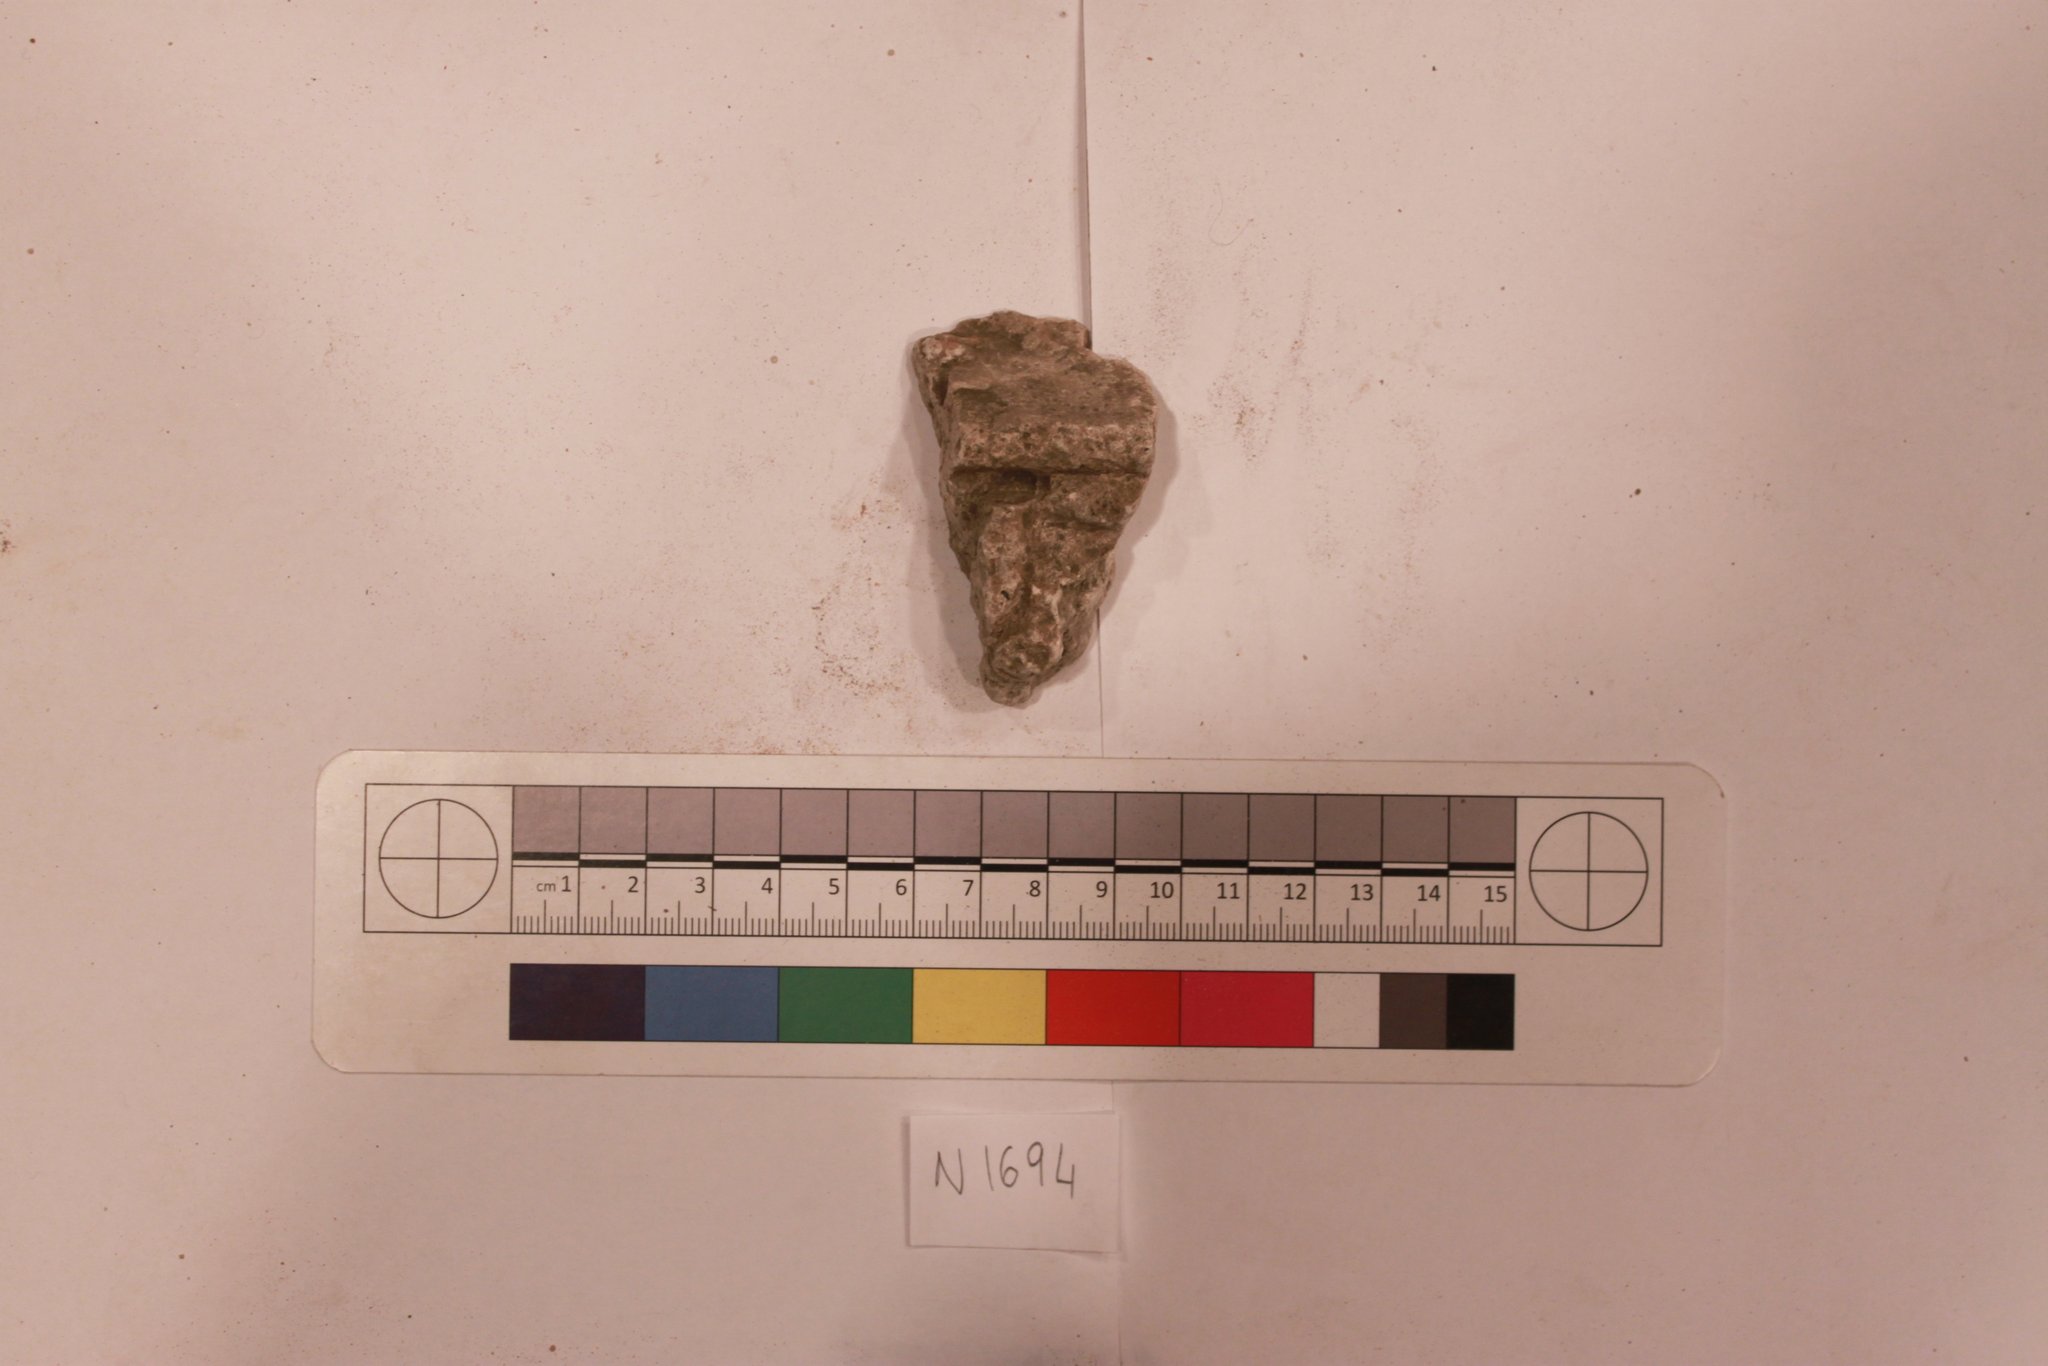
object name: fragment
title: Stucco Fragment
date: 701-1200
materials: plaster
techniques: carving, painting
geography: iran